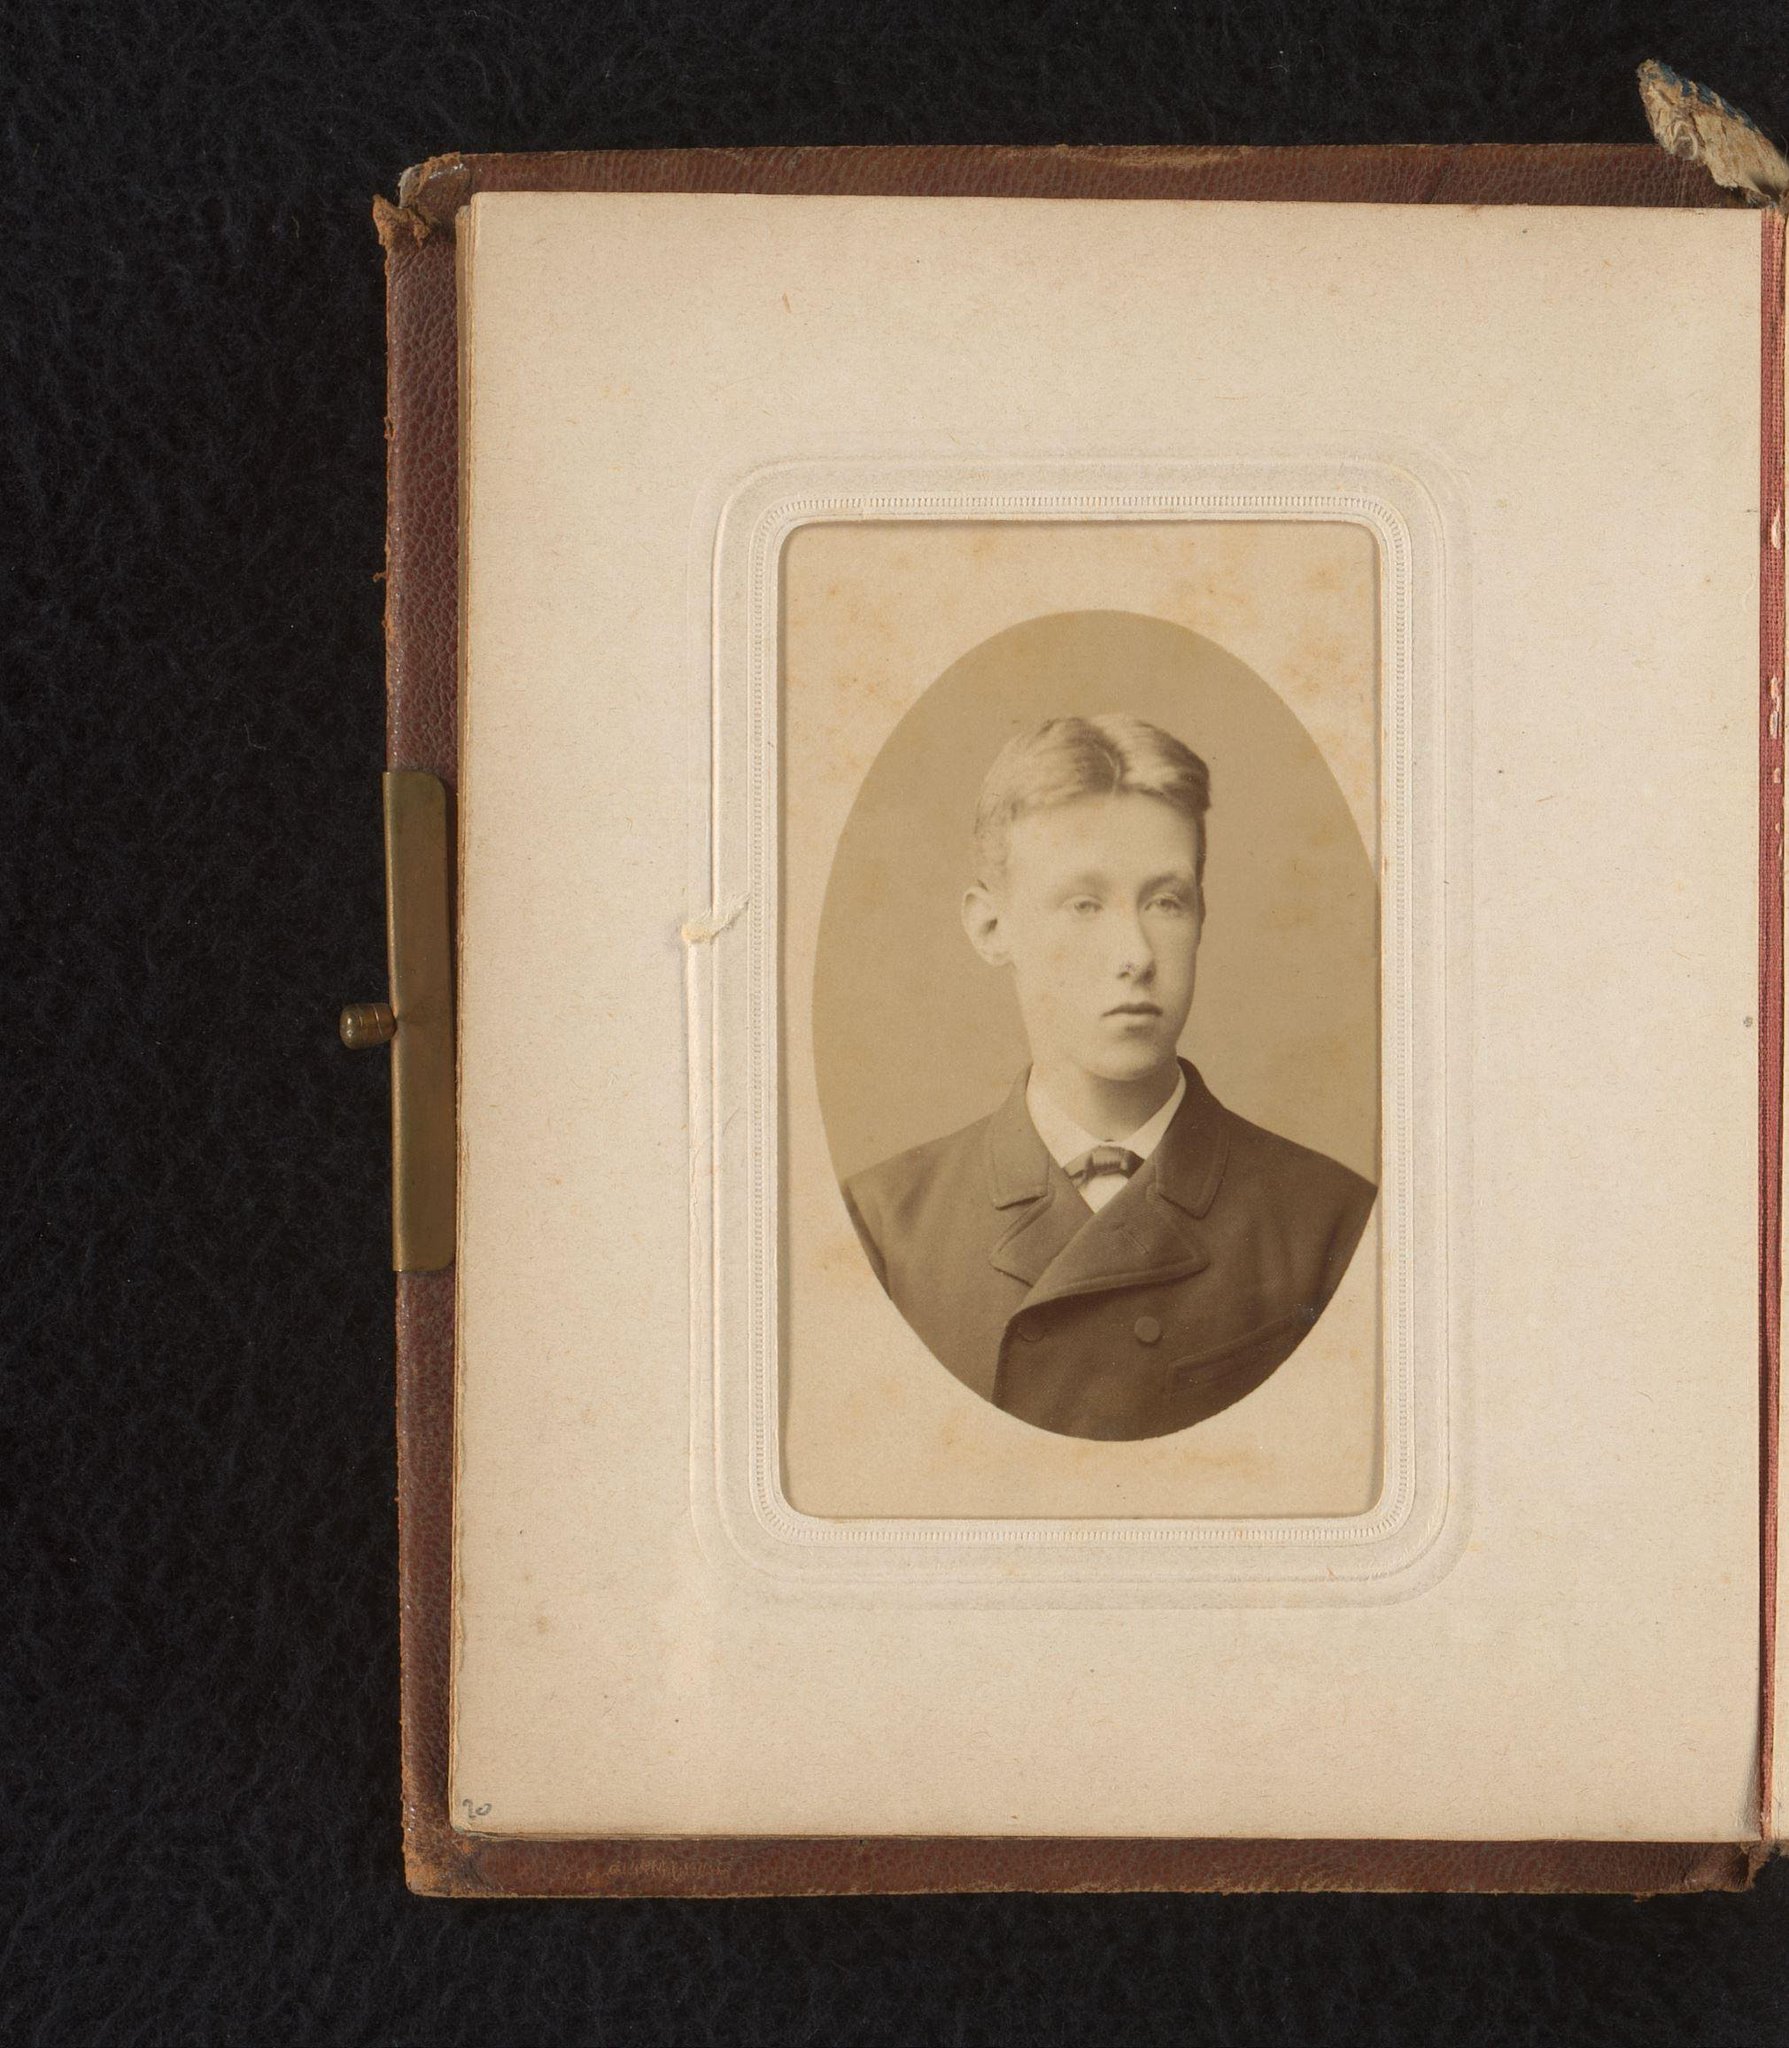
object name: photograph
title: Portret van een jongeman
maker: max büttinghausen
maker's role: fotograaf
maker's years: 1847-1906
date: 1873-1900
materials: cardboard, photographic support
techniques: albumen print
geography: amsterdam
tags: historical persons, youth, adolescent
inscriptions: inscription: ‘M. Büttinghausen/ Photografisch artistisch Atelier/ Amsterdam/ Singel bij het Koningsplein No. 512 (...)’